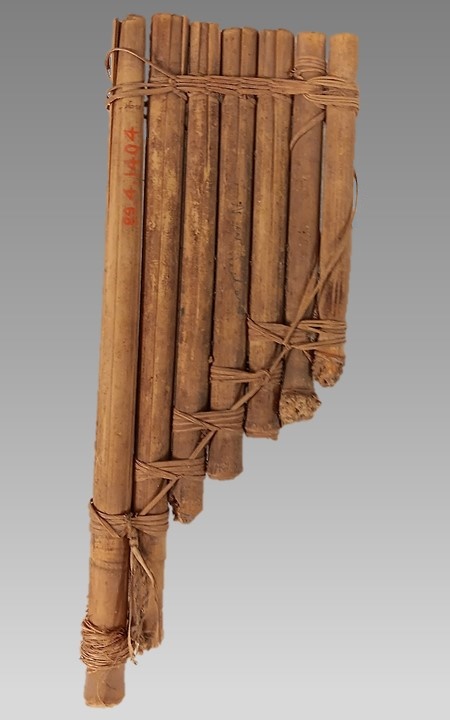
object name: panpipe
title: Panpipes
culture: melanesian, new ireland or papua new guinean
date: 1867-1900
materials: bamboo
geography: papua new guinea